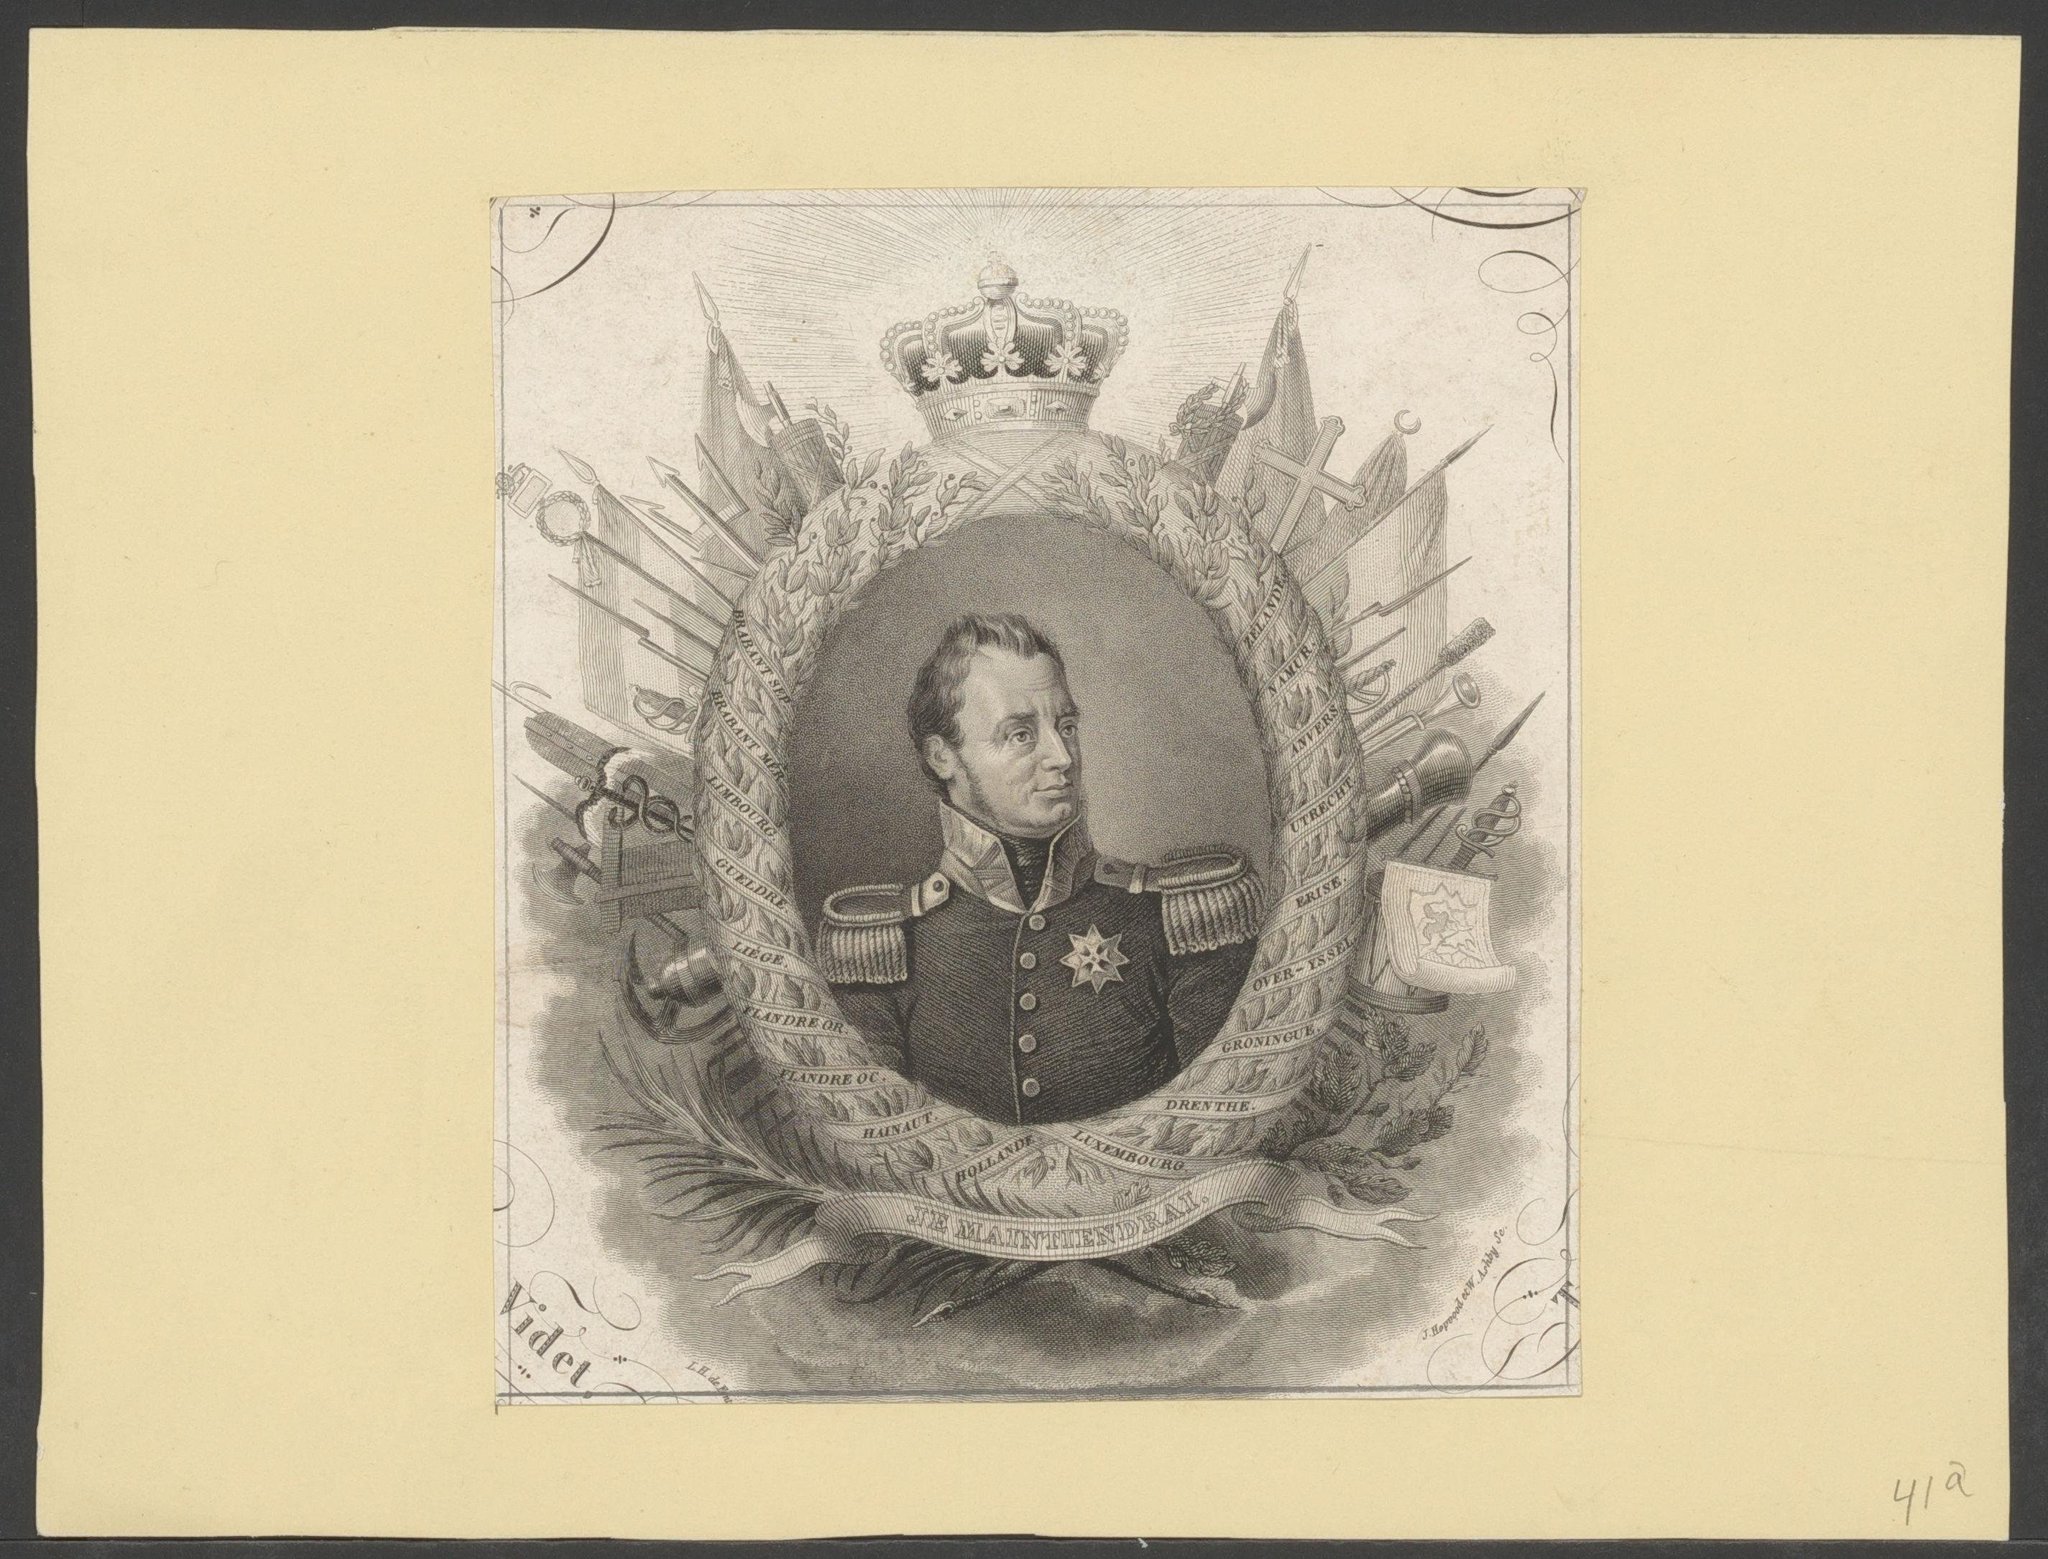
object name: print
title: Portret van Willem I Frederik, koning der Nederlanden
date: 1830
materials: paper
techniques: engraving, etching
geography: brussels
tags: the hague, berlin, william i of the netherlands, historical persons, king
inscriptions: stamp, collector's mark: Lugt 1641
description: Portret van Willem I Frederik in een ovaal van eikenbladen. Daar omheen een aantal allegorische objecten. Midden boven een kroon. Midden onder op een banderol zijn geslachtsspreuk. Onderwerpsrubrieken binnen de Atlas Zeden en Gewoonten: Portretten, Portretten van Vorsten uit het huis van Oranje, Regeerende Vorsten, Koningen uit het huis van Oranje.